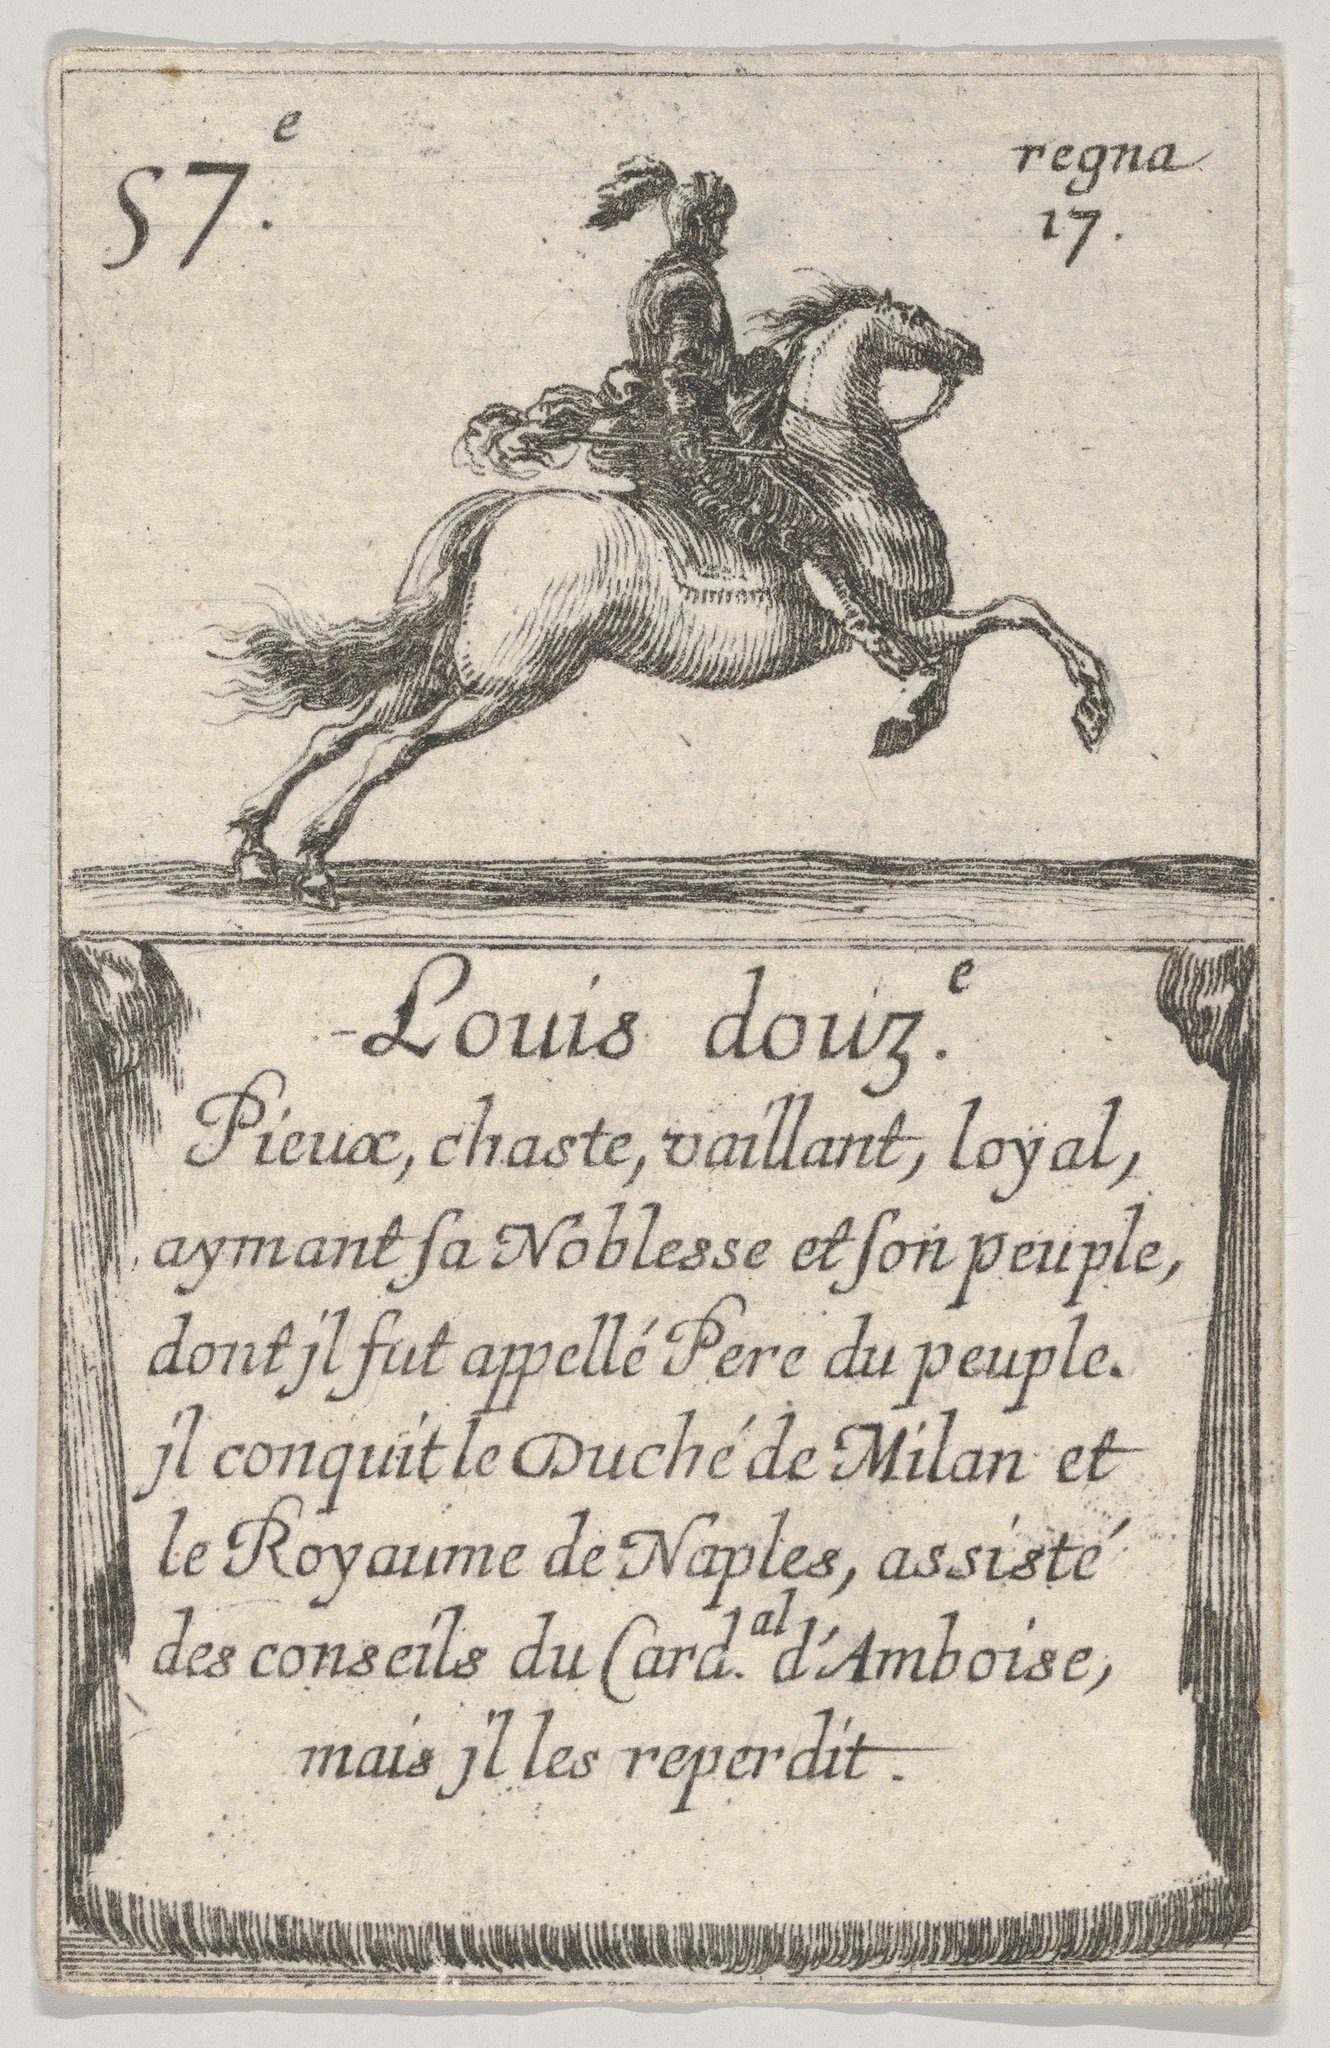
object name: print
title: Louis douz.-e / Pieux, chaste..., from "Game of the Kings of France" (Jeu des Rois de France)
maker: stefano della bella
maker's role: artist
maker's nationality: italian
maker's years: 1610-1664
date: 1644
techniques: etching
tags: kings,horses